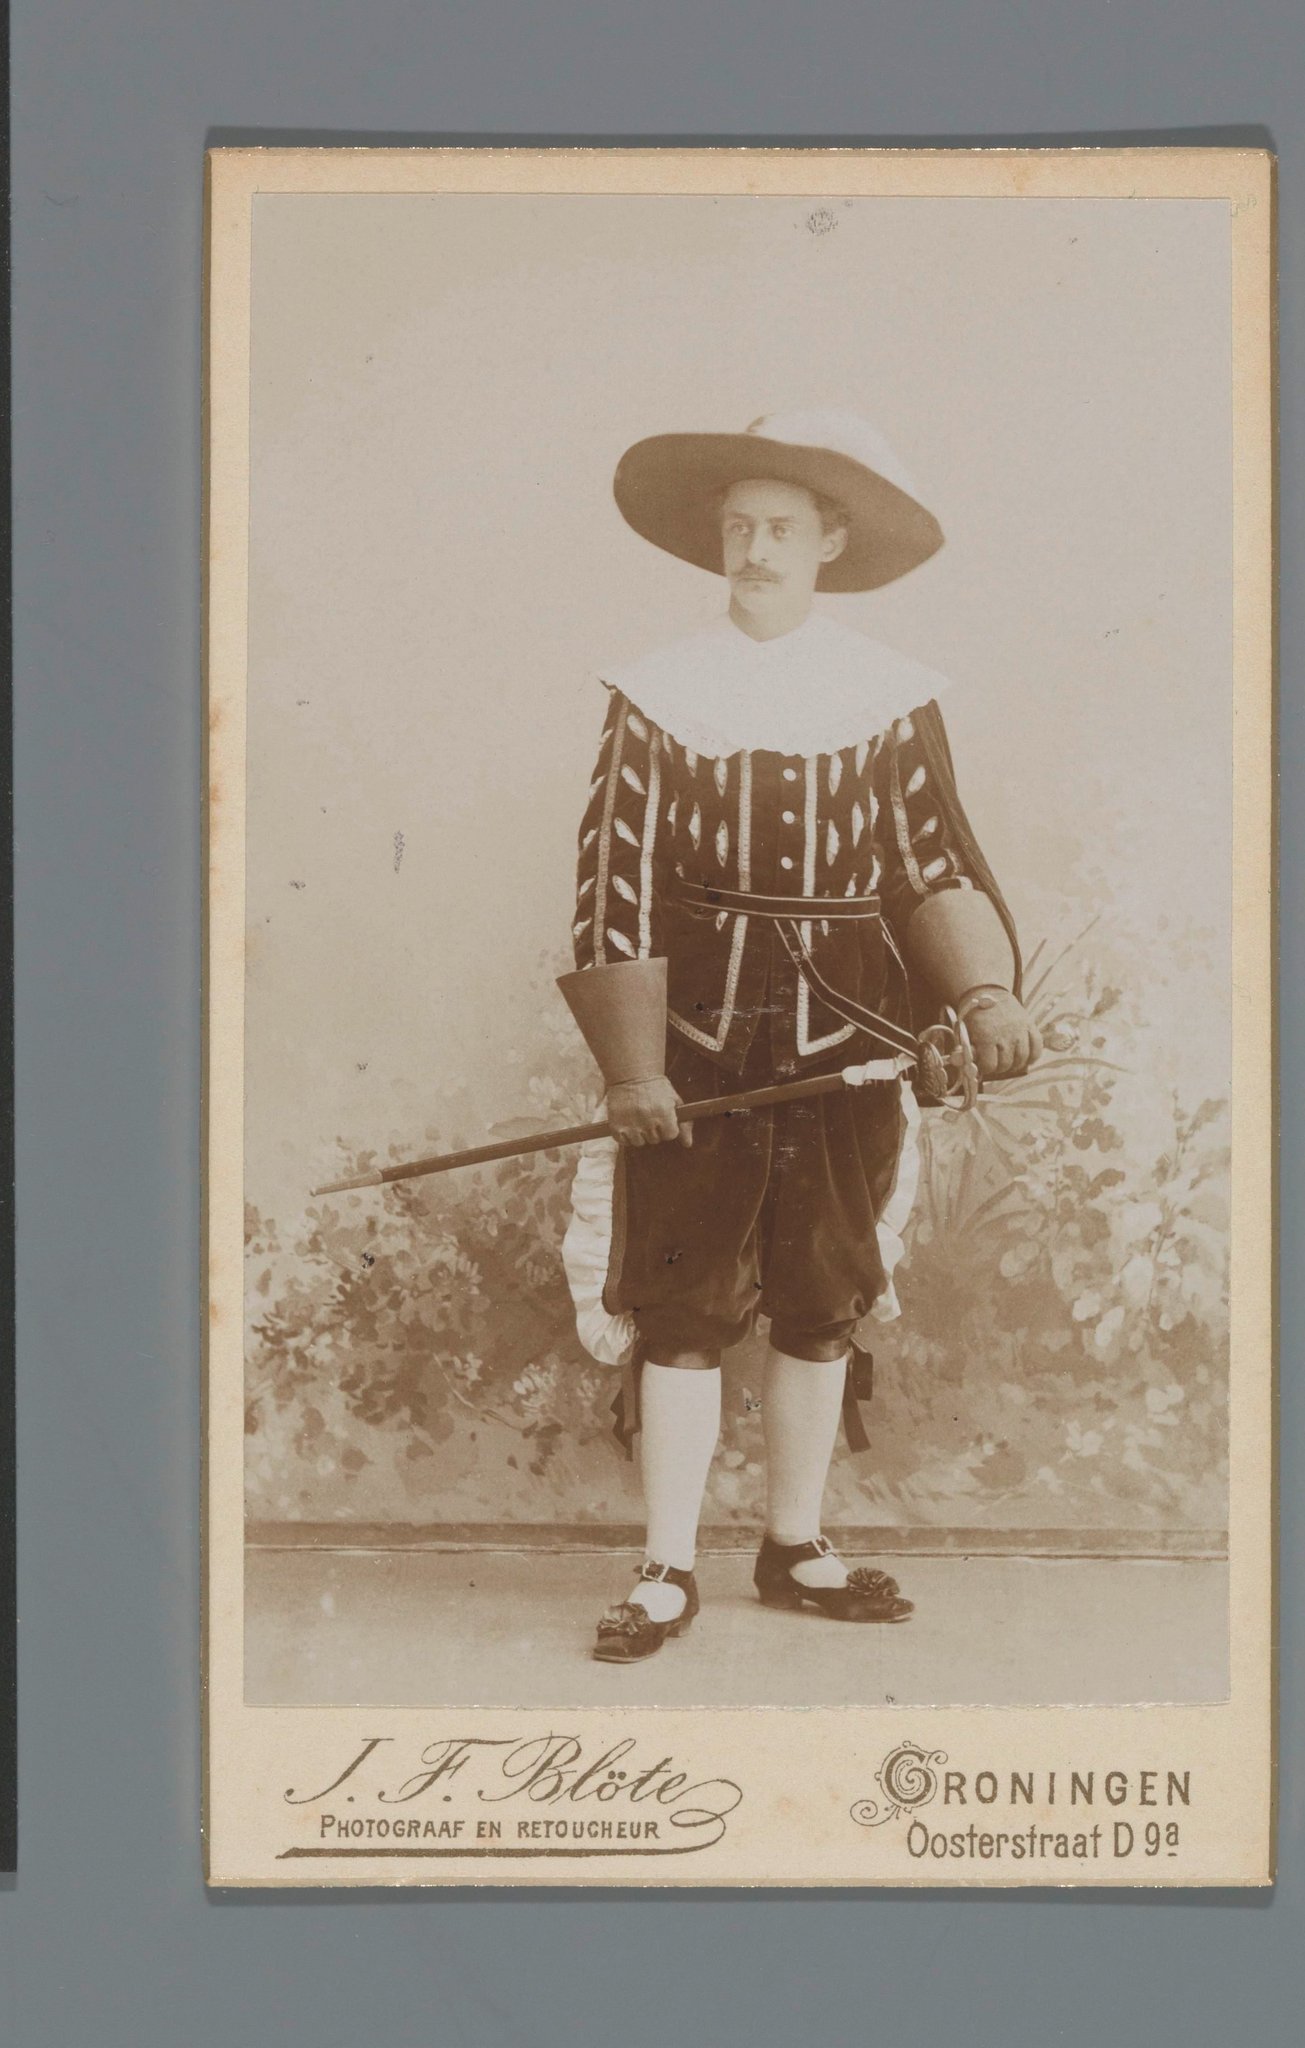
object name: photograph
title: Portret van een onbekende Groningse student in maskeradekostuum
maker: jan frederik blöte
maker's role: fotograaf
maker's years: 1865-1956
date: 1896-1900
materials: paper, cardboard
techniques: collodion silver print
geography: groningen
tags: students' pageant, costumes used in pageants, anonymous historical person portrayed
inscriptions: inscription: ‘J.F. Blöte/ Photograaf en retoucheur/ Groningen/ Oosterstraat D9a’